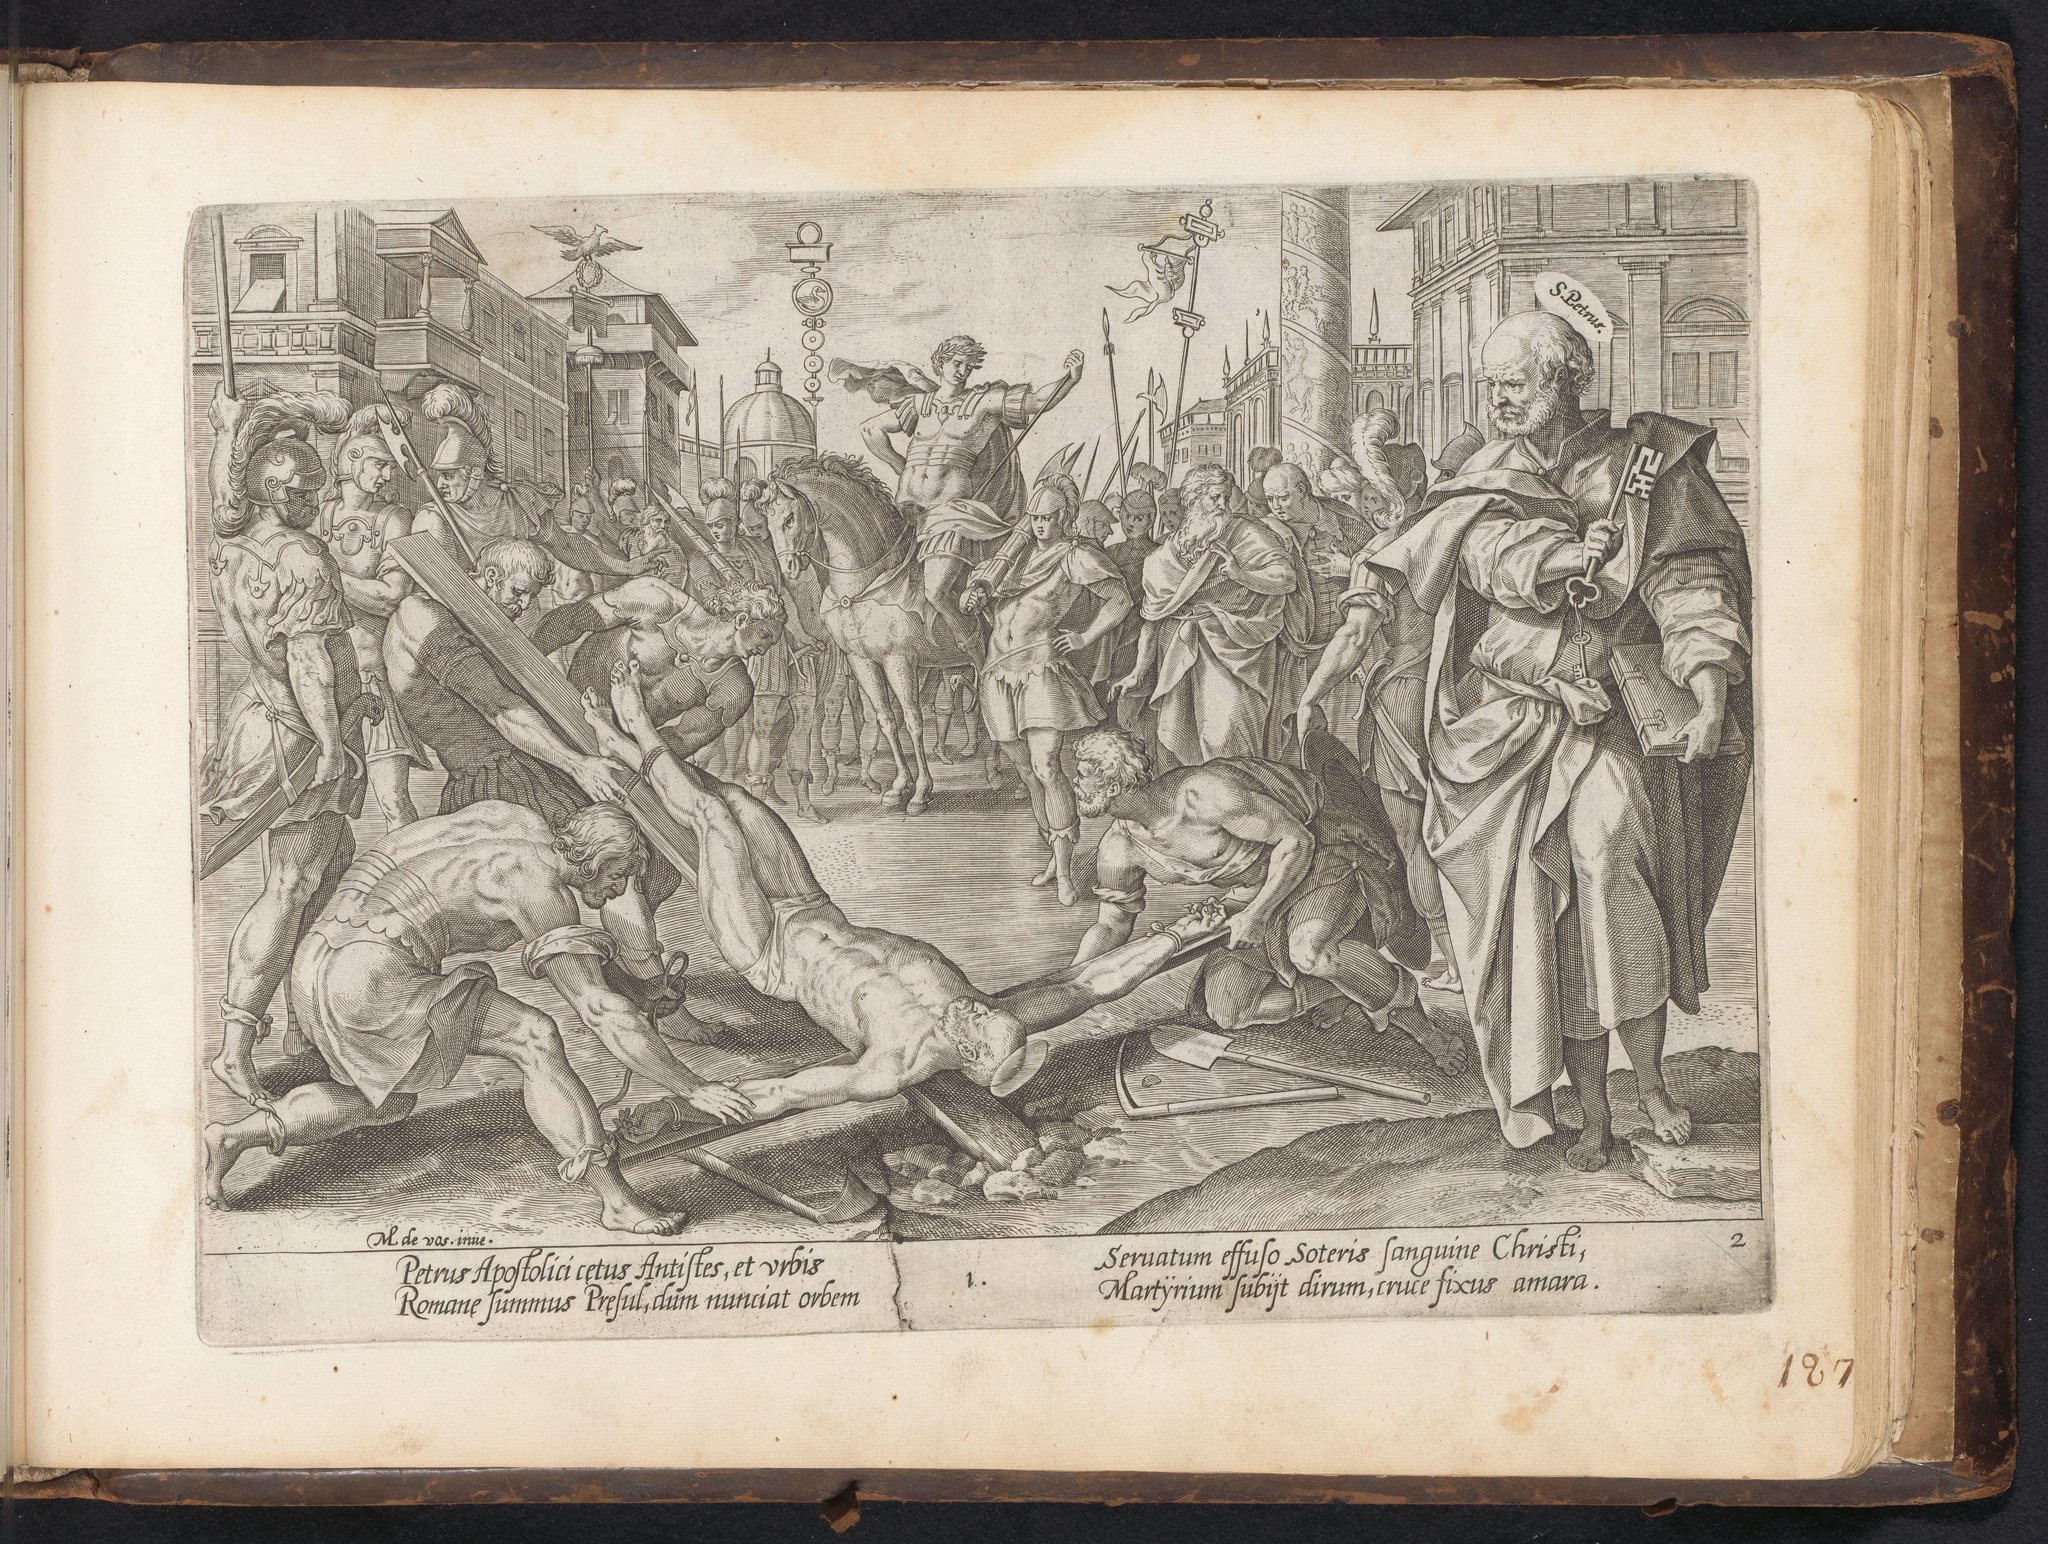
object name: print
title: Martelaarschap van Christus en de apostelen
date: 1576-1580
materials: paper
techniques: engraving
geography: alkmaar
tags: peter crucified upside down, the apostle peter, first bishop of rome; possible attributes: book, cock, (upturned) cross, (triple) crozier, fish, key, scroll, ship, tiara - martyrdom, suffering, misfortune, death of male saint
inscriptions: number: ‘187’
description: Petrus wordt ondersteboven gekruisigd. Rechts naast het tafereel van zijn marteldood staat hij nogmaals afgebeeld met sleutels in de hand. Onder de voorstelling een verklarende tekst in het Latijn. Deze prent maakt deel uit van een album.